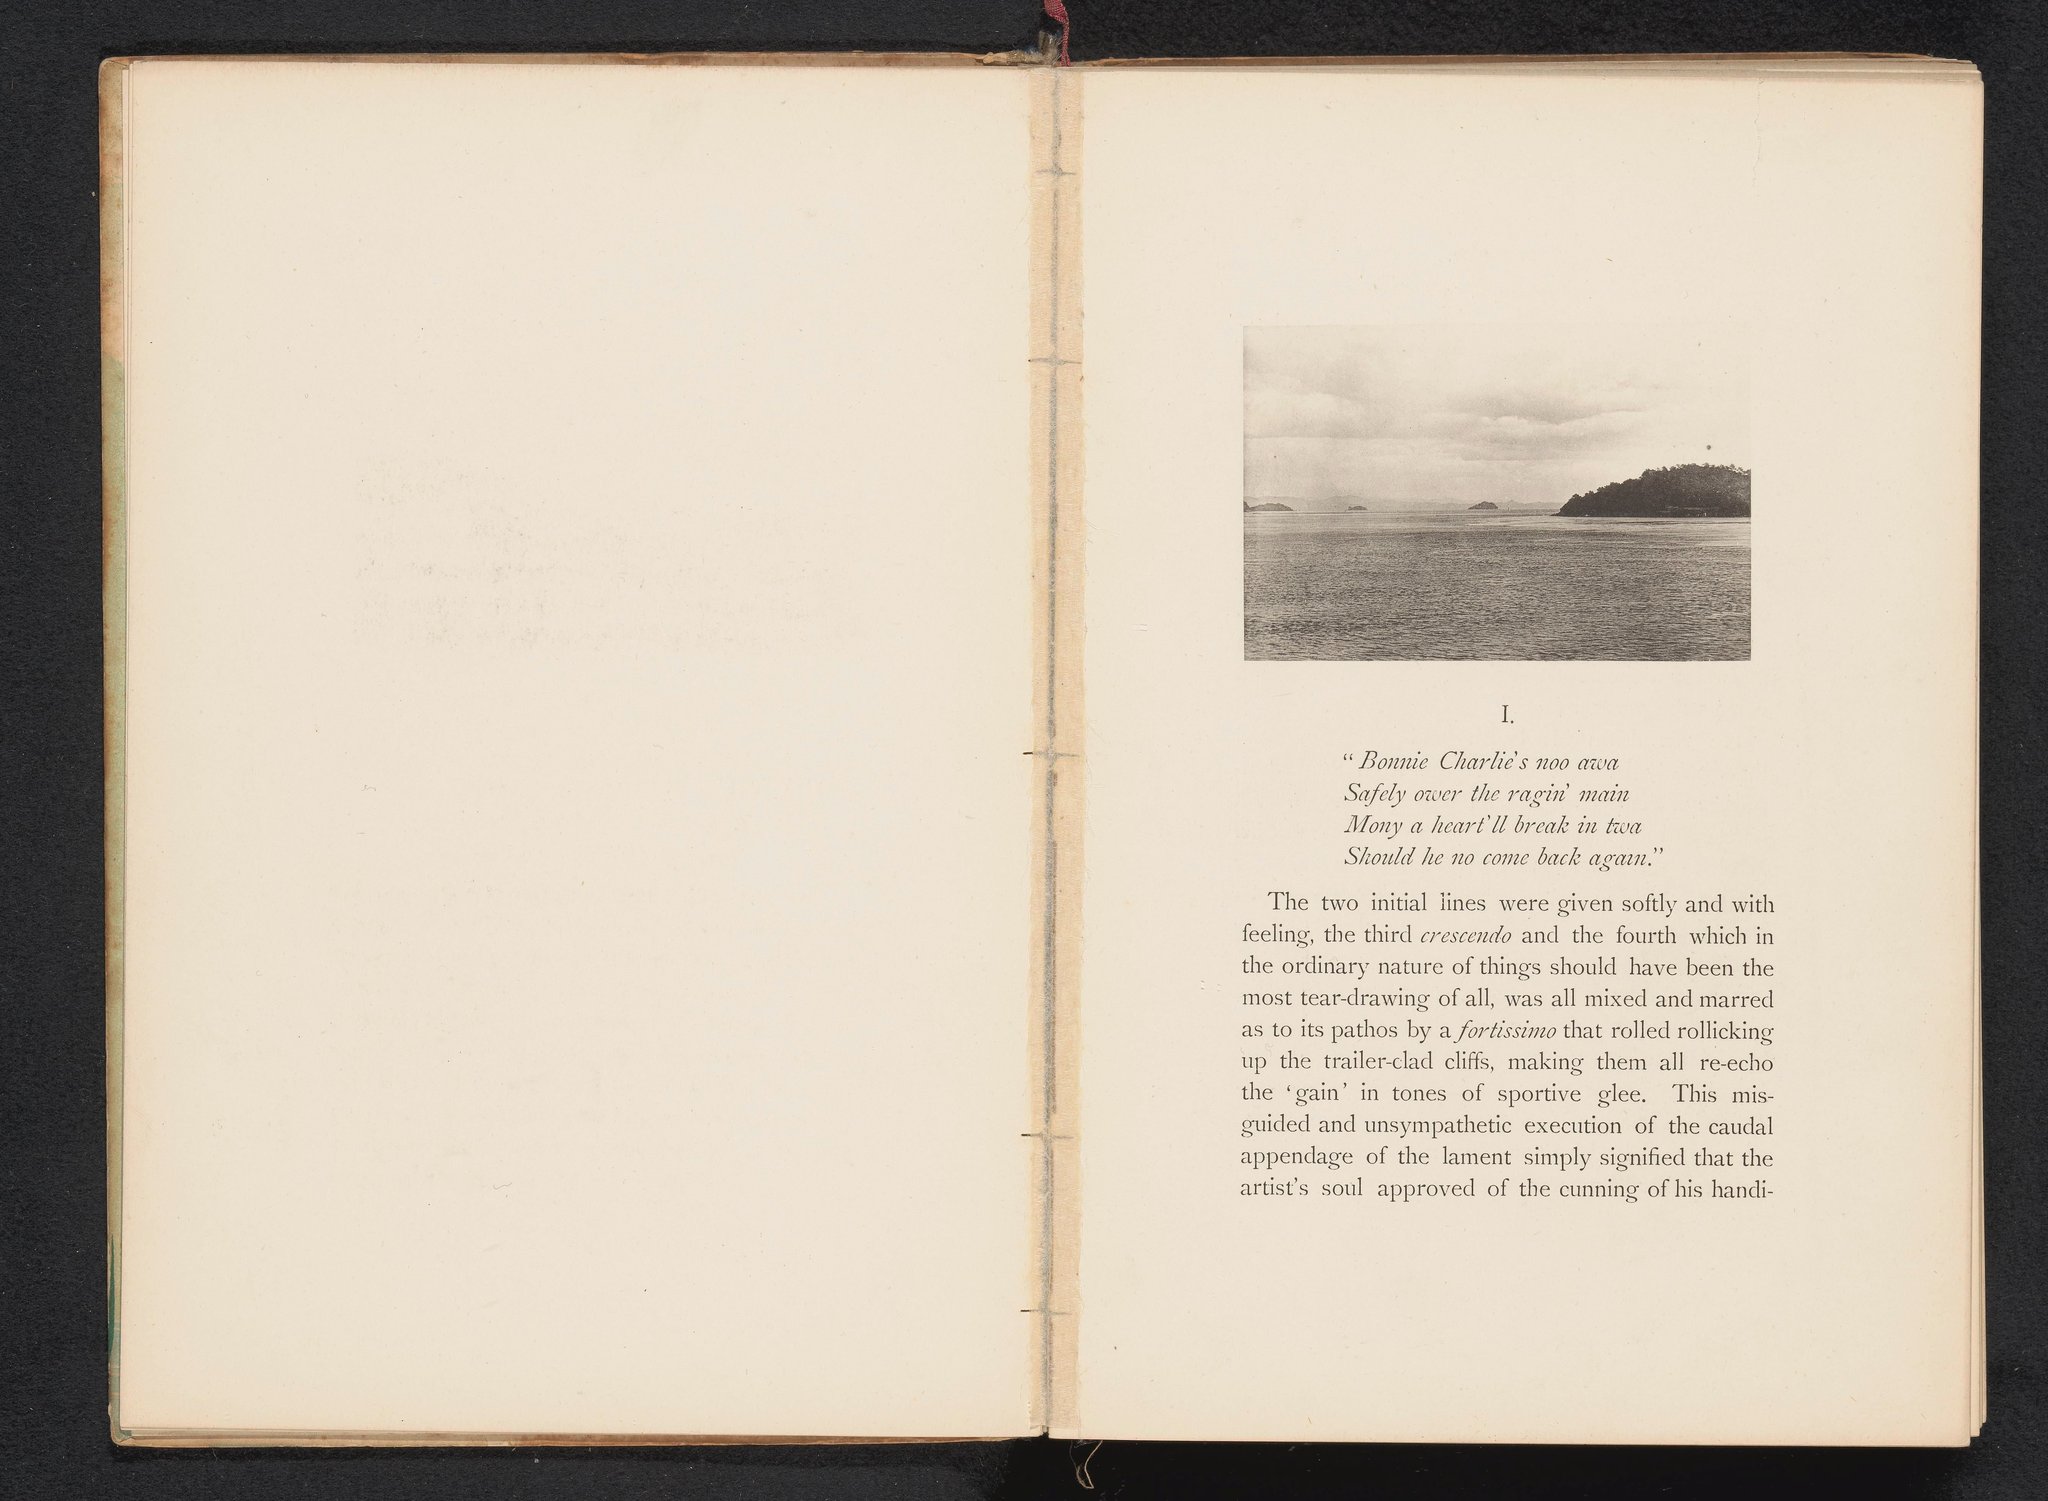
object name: photomechanical print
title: Gezicht op een baai te Japan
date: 1882-1892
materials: paper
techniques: photograph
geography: japan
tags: gulf, bay